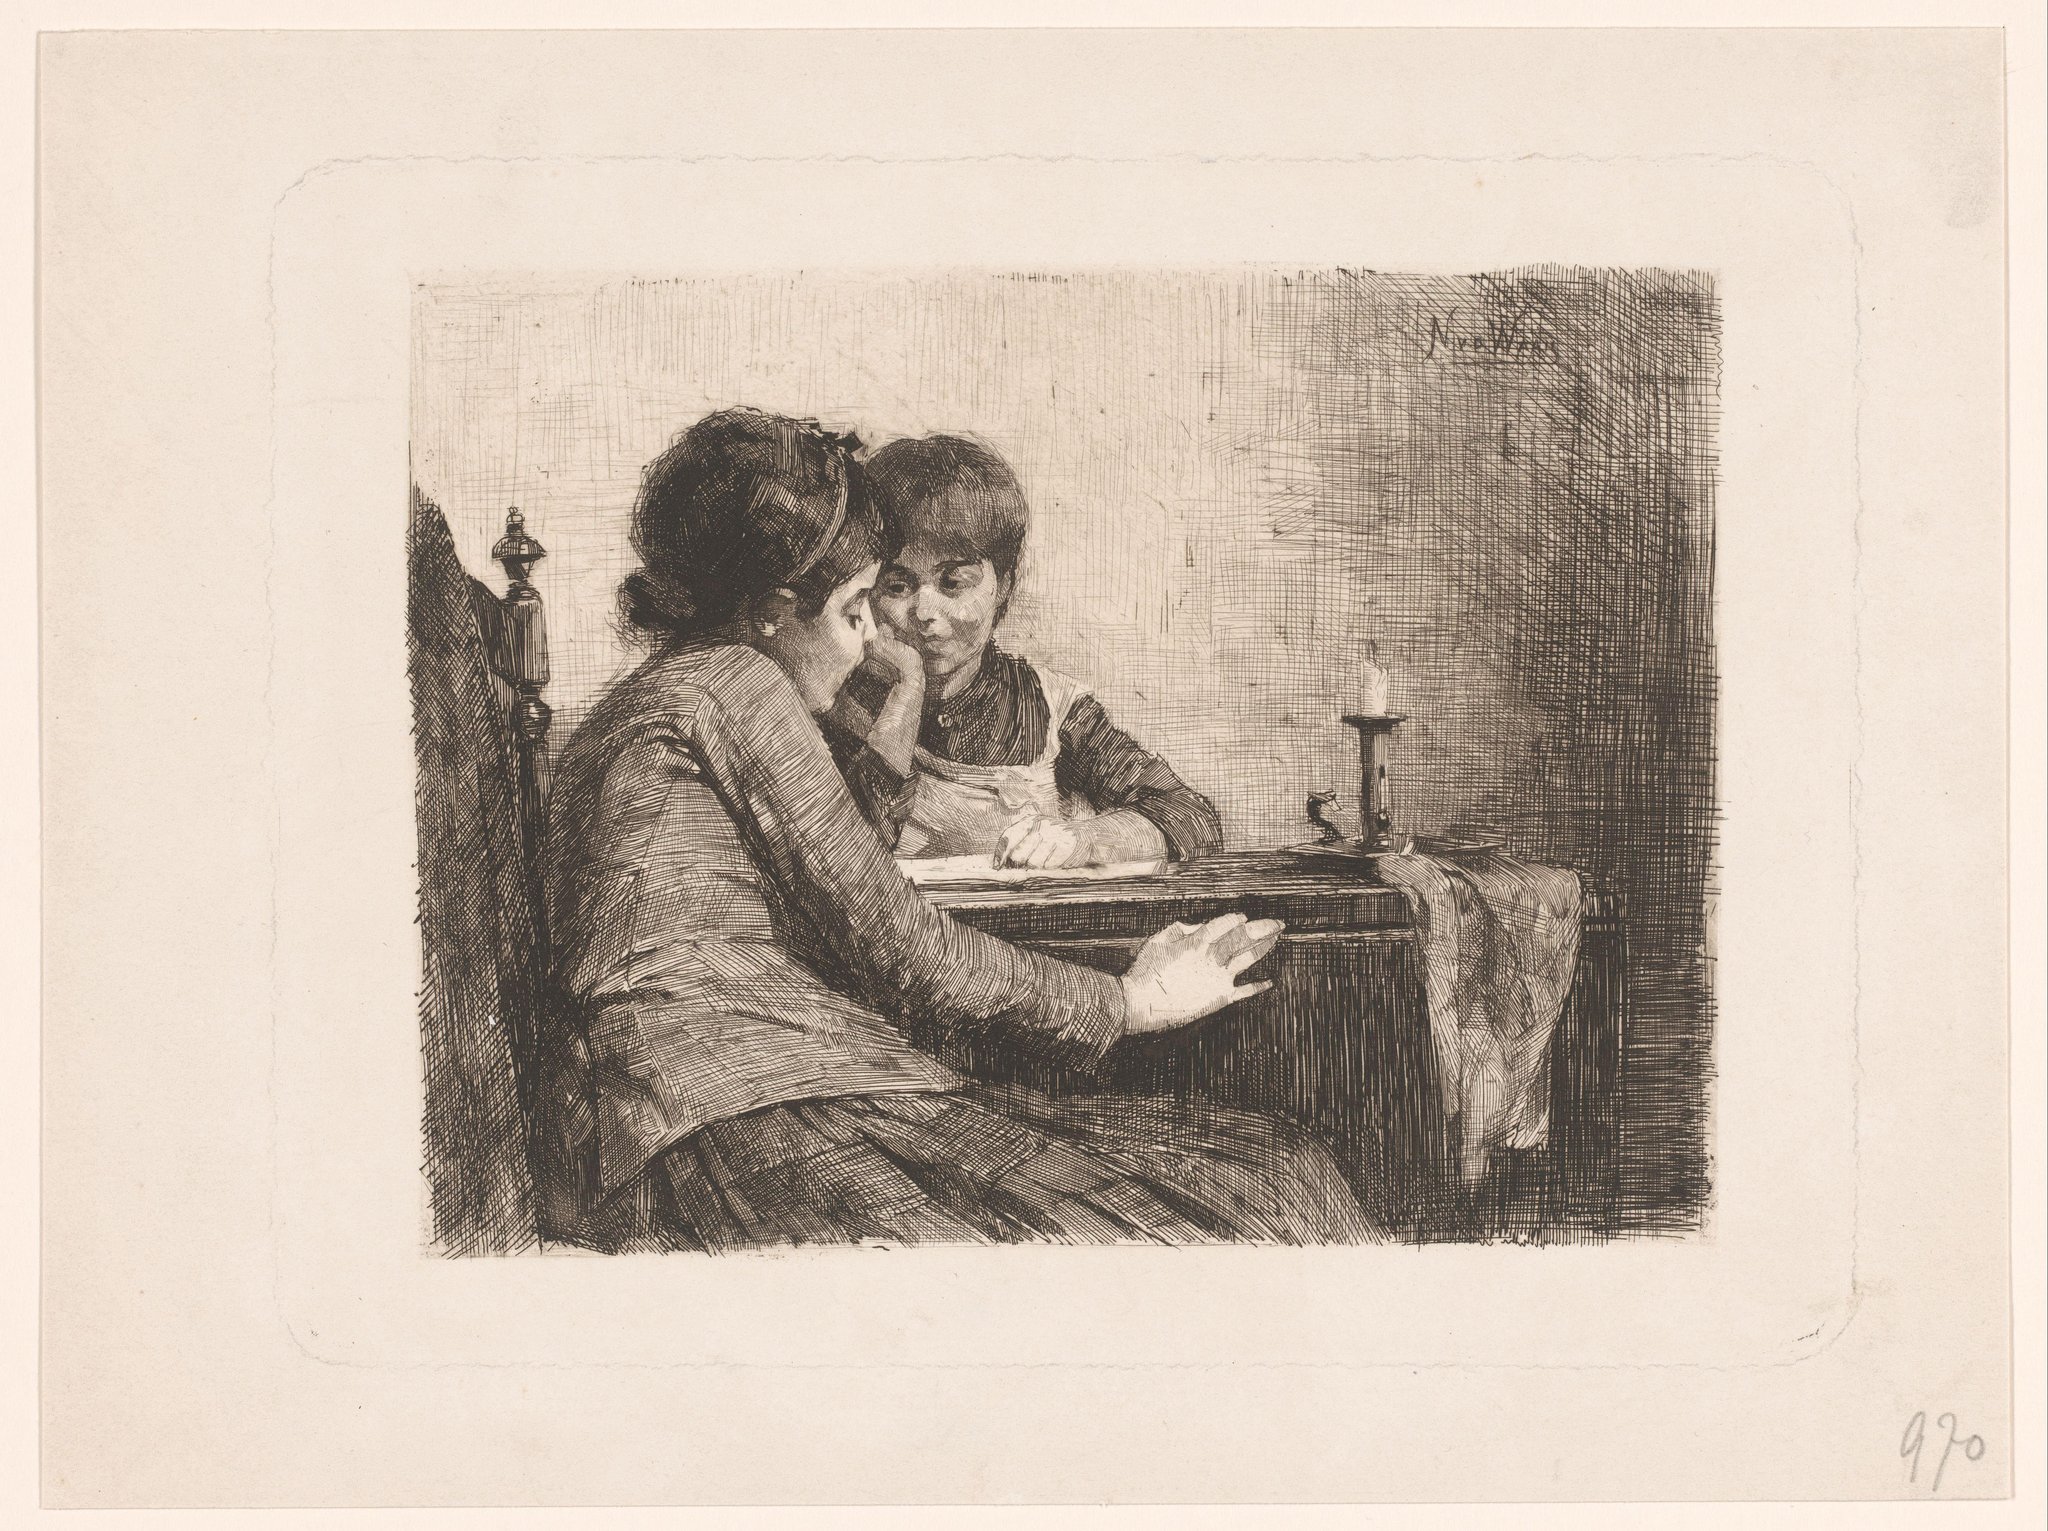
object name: print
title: Kunstbeschouwing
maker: nicolaas van der waay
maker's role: draughtsman, painter, print maker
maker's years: 1855-1936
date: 1865-1936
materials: paper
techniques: drypoint, etching, intaglio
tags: child and art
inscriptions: collector's mark: Lugt 2760, collector's mark: Lugt 2228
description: Twee kinderen met een boek dat open op een tafel ligt.